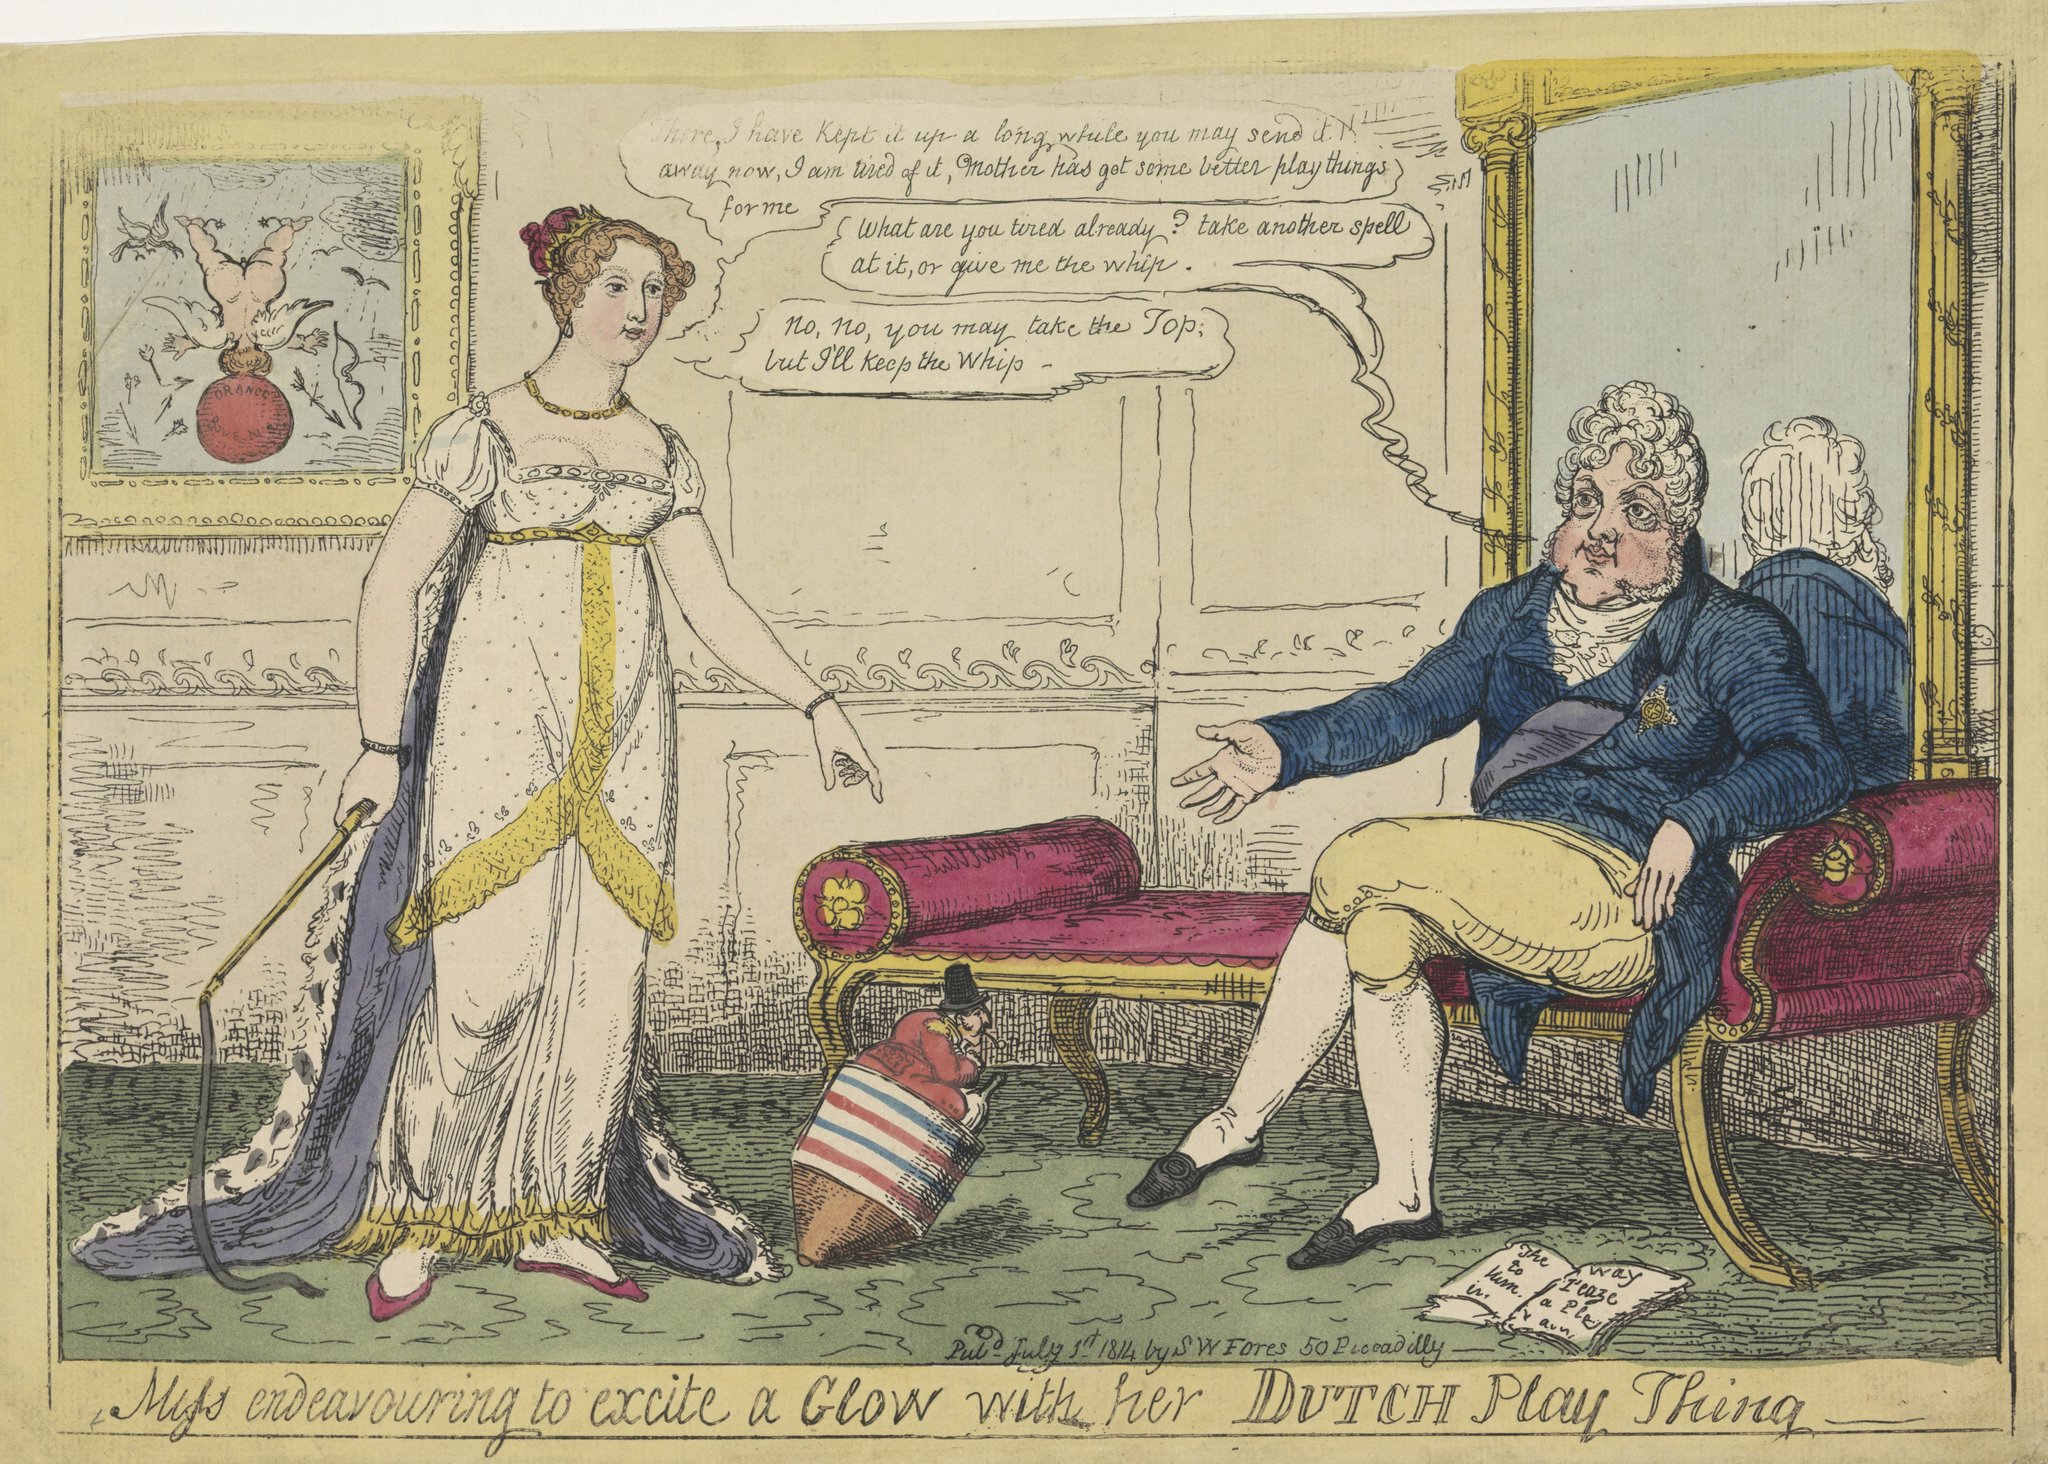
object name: print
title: Miss endeavouring to excite a Glow with her Dutch Play Thing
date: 1814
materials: paper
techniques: etching, hand coloring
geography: england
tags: the hague, william ii of the netherlands, charlotte augusta (prinses van wales), george iv (koning van het verenigd koninkrijk), whipping a top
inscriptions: collector's mark: Lugt 2228, collector's mark: Lugt 2760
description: Prinses Charlotte staande met zweepje vertelt aan op de bank zittende koning George IV dat ze uitgespeeld is met de tol. Op de tol is een zittende figuurtje, een Hollander, afgebeeld. Op de wand achter de vrouw een schilderij waarop een Cupido op z'n kop op een bol 'Orange Boven' staat. Prinses Charlotte van Engeland, die enige tijd verloofd is geweest met de prins van Oranje Willem (de latere Koning Willem II). Zij verbrak de verloving op 16 juni 1814.